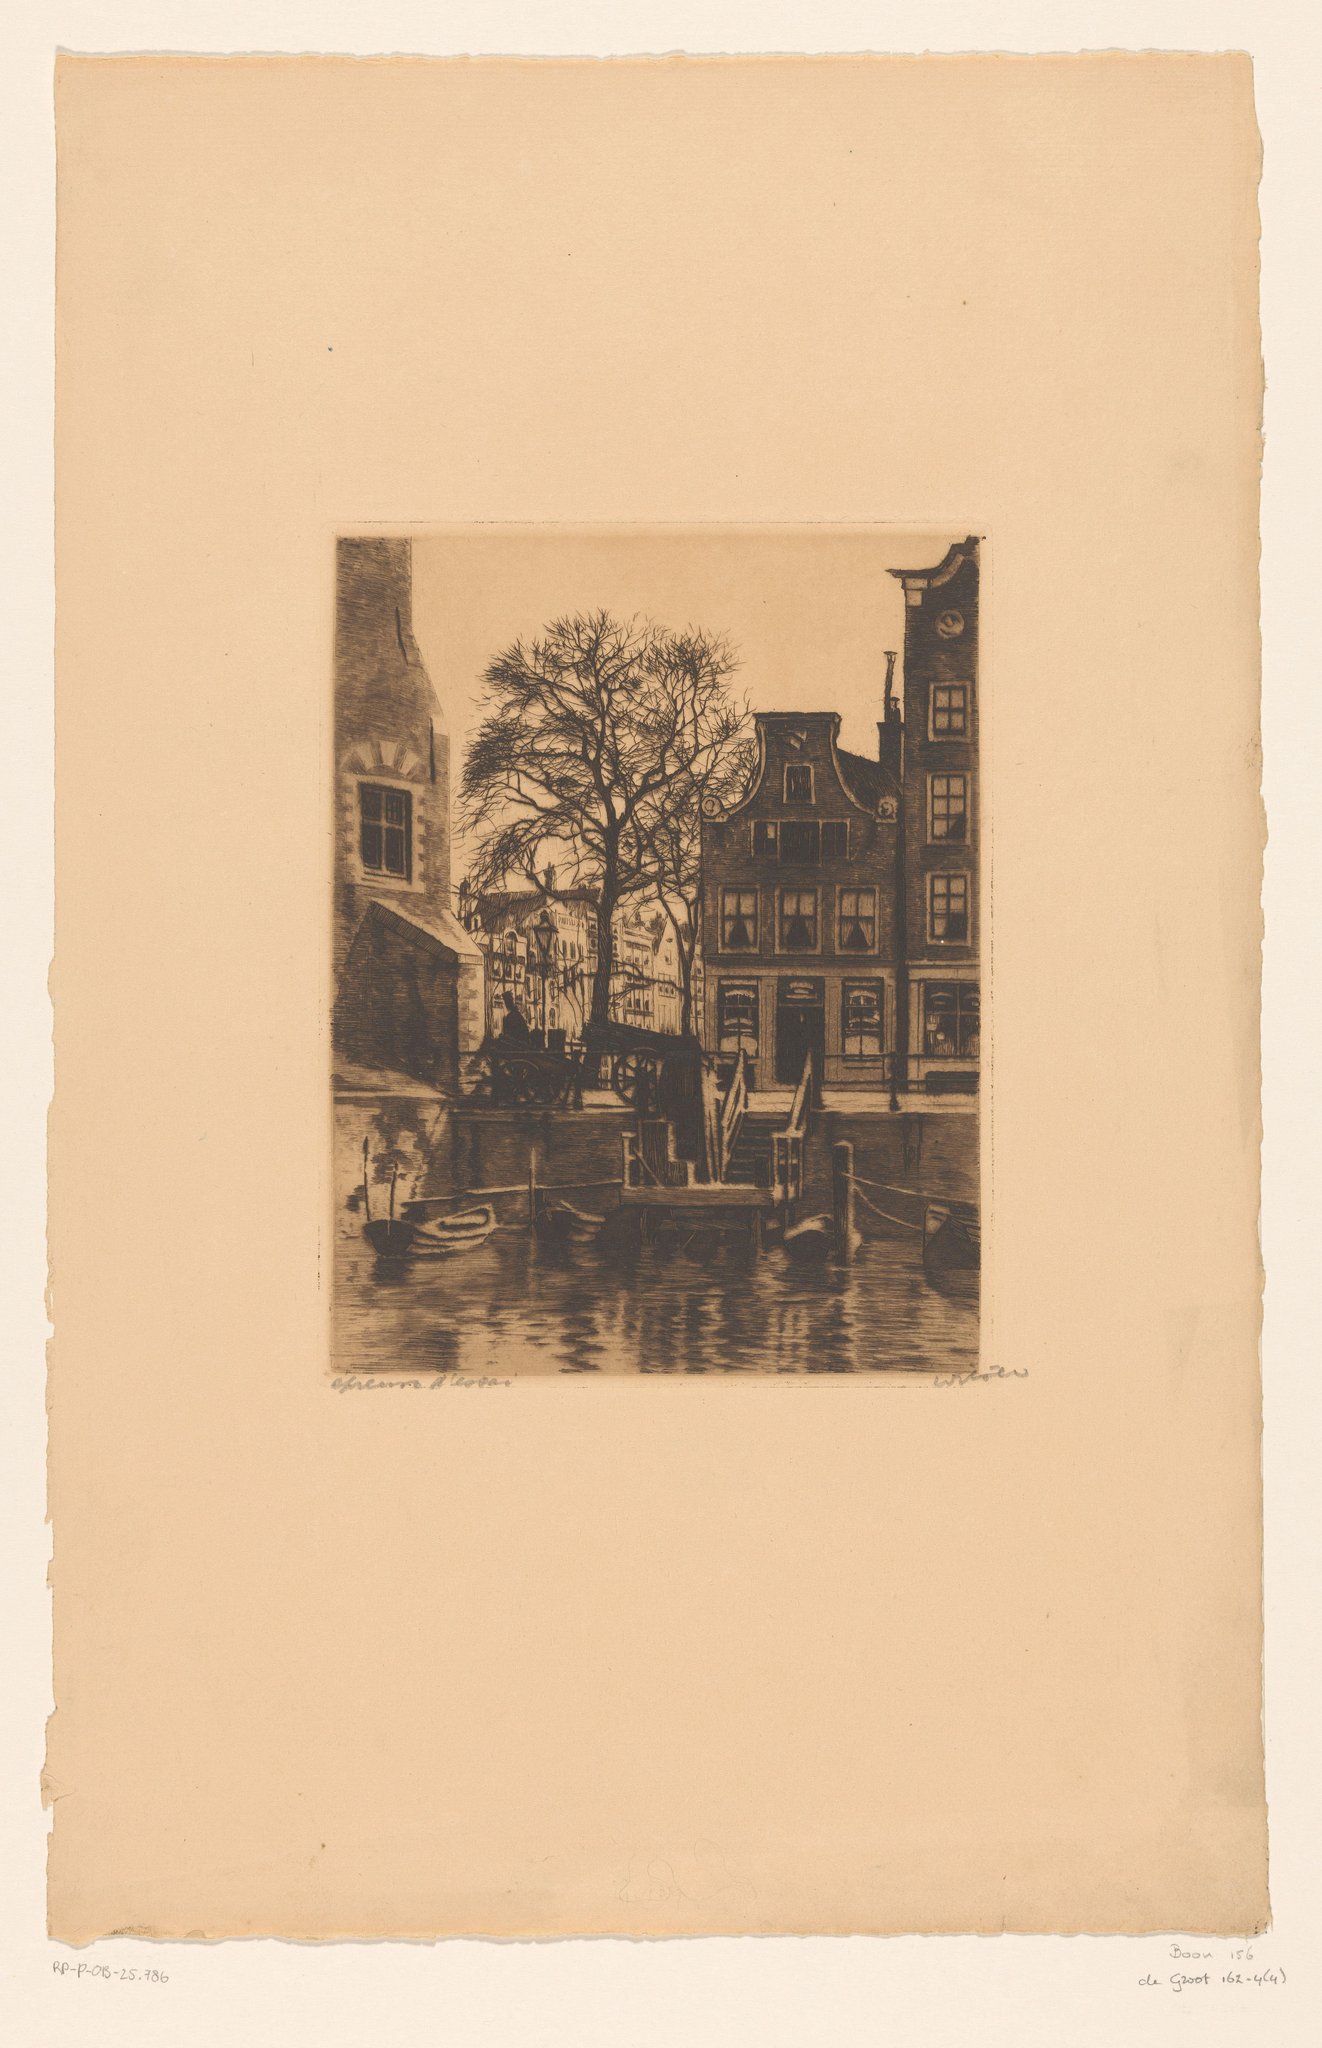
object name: print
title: Overhaal bij de Montelbaanstoren in Amsterdam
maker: willem witsen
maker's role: draughtsman, painter, print maker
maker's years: 1860-1923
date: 1912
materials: paper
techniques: aquatint, etching, intaglio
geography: amsterdam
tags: city-view, and landscape with man-made constructions, canals, waters (in city), the usual house or row of houses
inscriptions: watermark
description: Gezien vanaf de Oude Schans richting de Oude Schans 4.